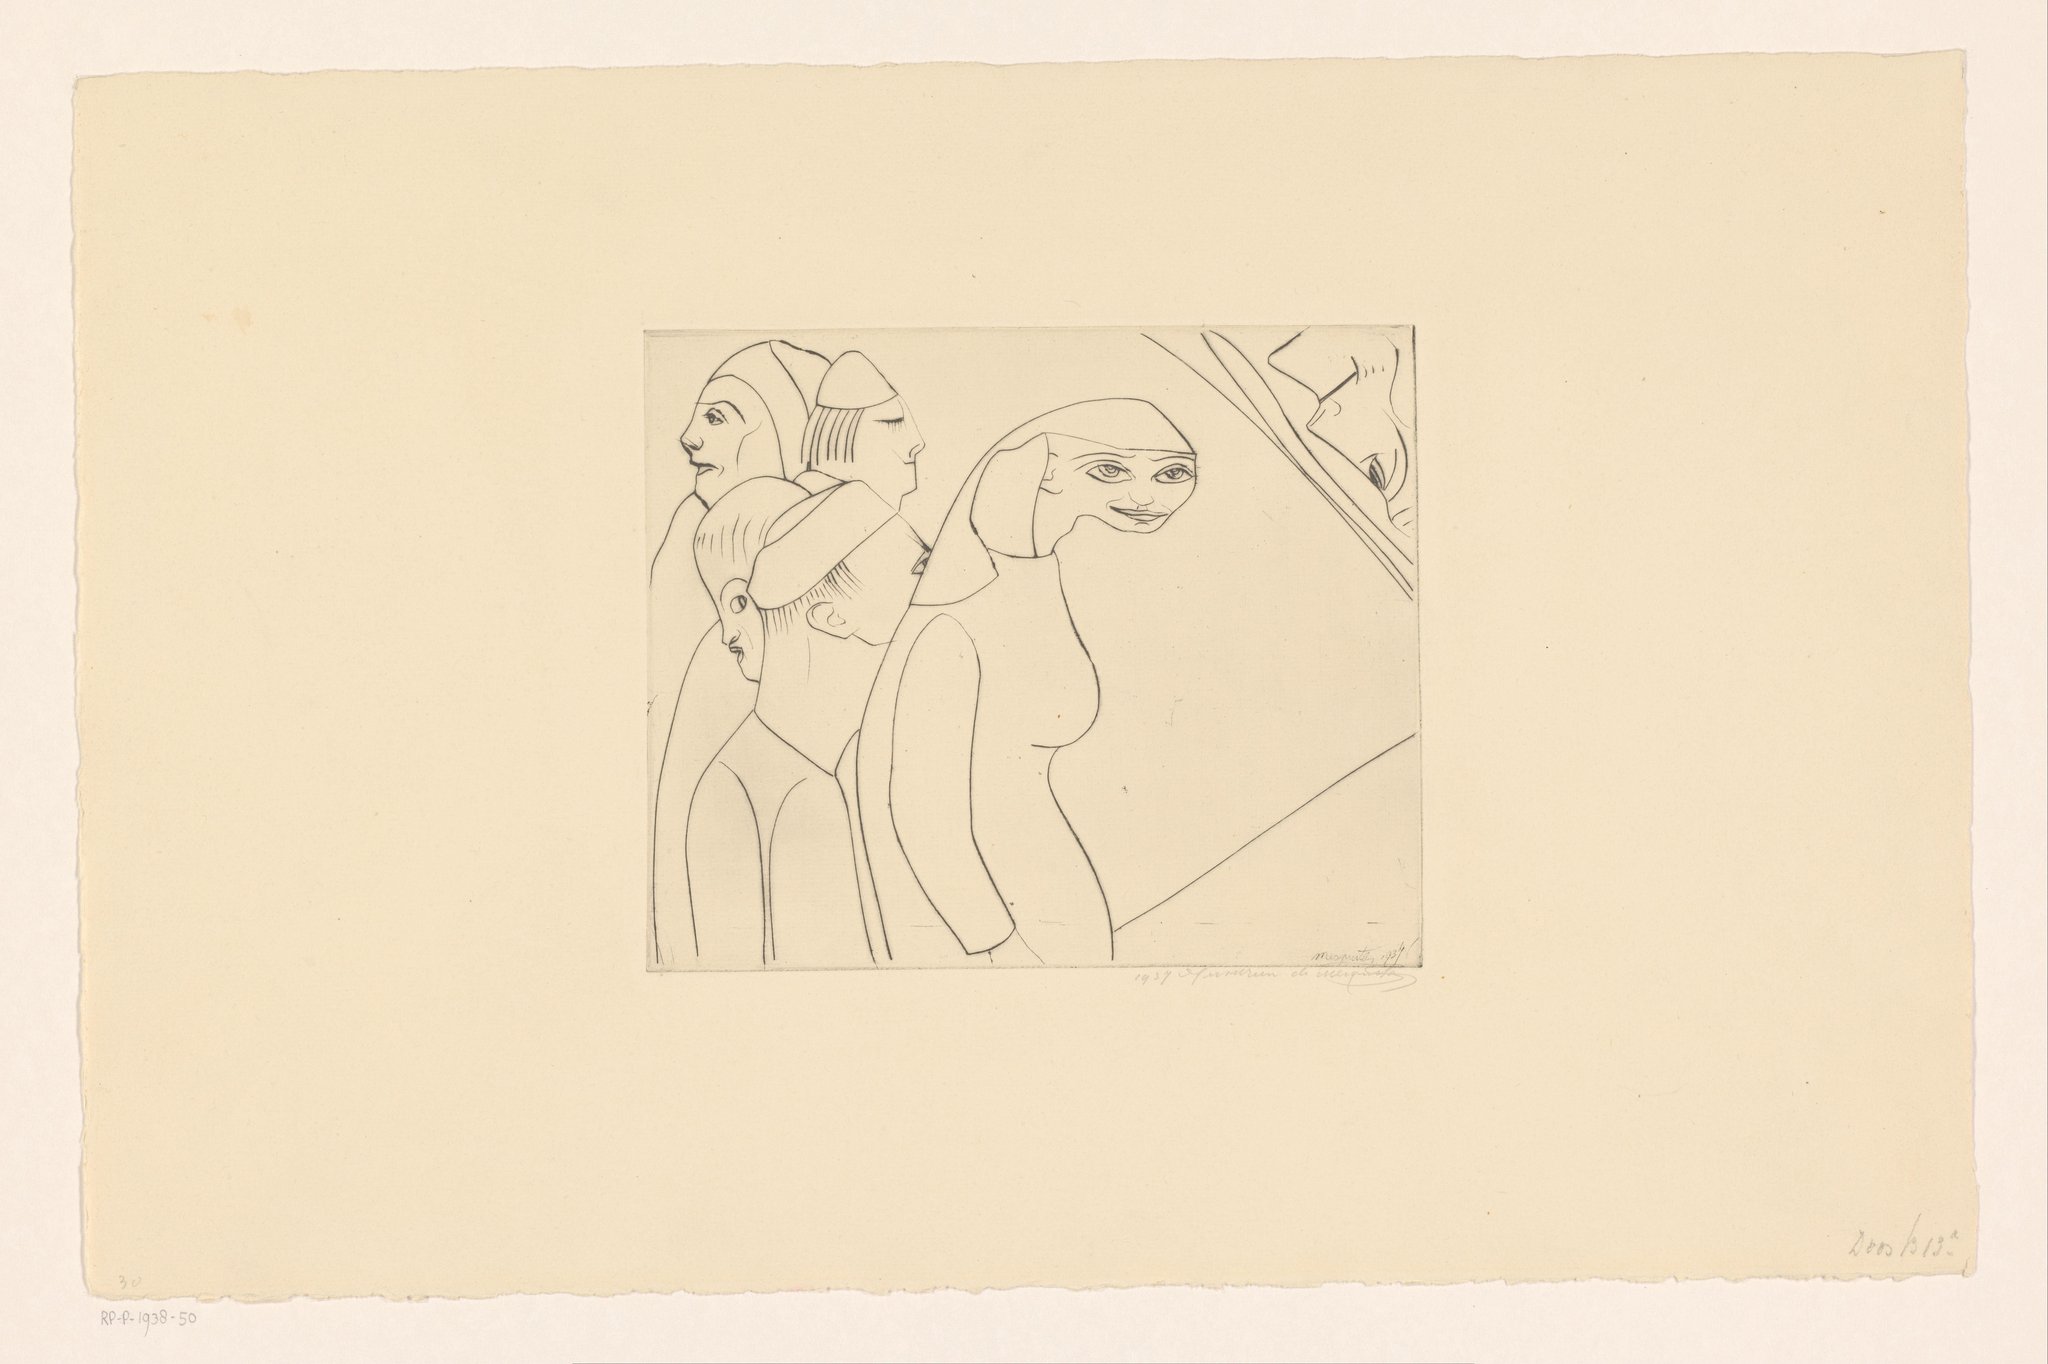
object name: print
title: Fantasie: links vijf halffiguren (de voorste een vrouw), rechtsboven een profielkop, ondersteboven het beeld in komend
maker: samuel jessurun de mesquita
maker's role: draughtsman, print maker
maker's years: 1868-1944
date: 1937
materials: paper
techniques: drypoint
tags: caricatures (human types)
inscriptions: collector's mark: Lugt 2228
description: Groep van vijf figuren; in het midden een vrouw. Zij kijkt naar een gezicht in de hoek rechtsboven.